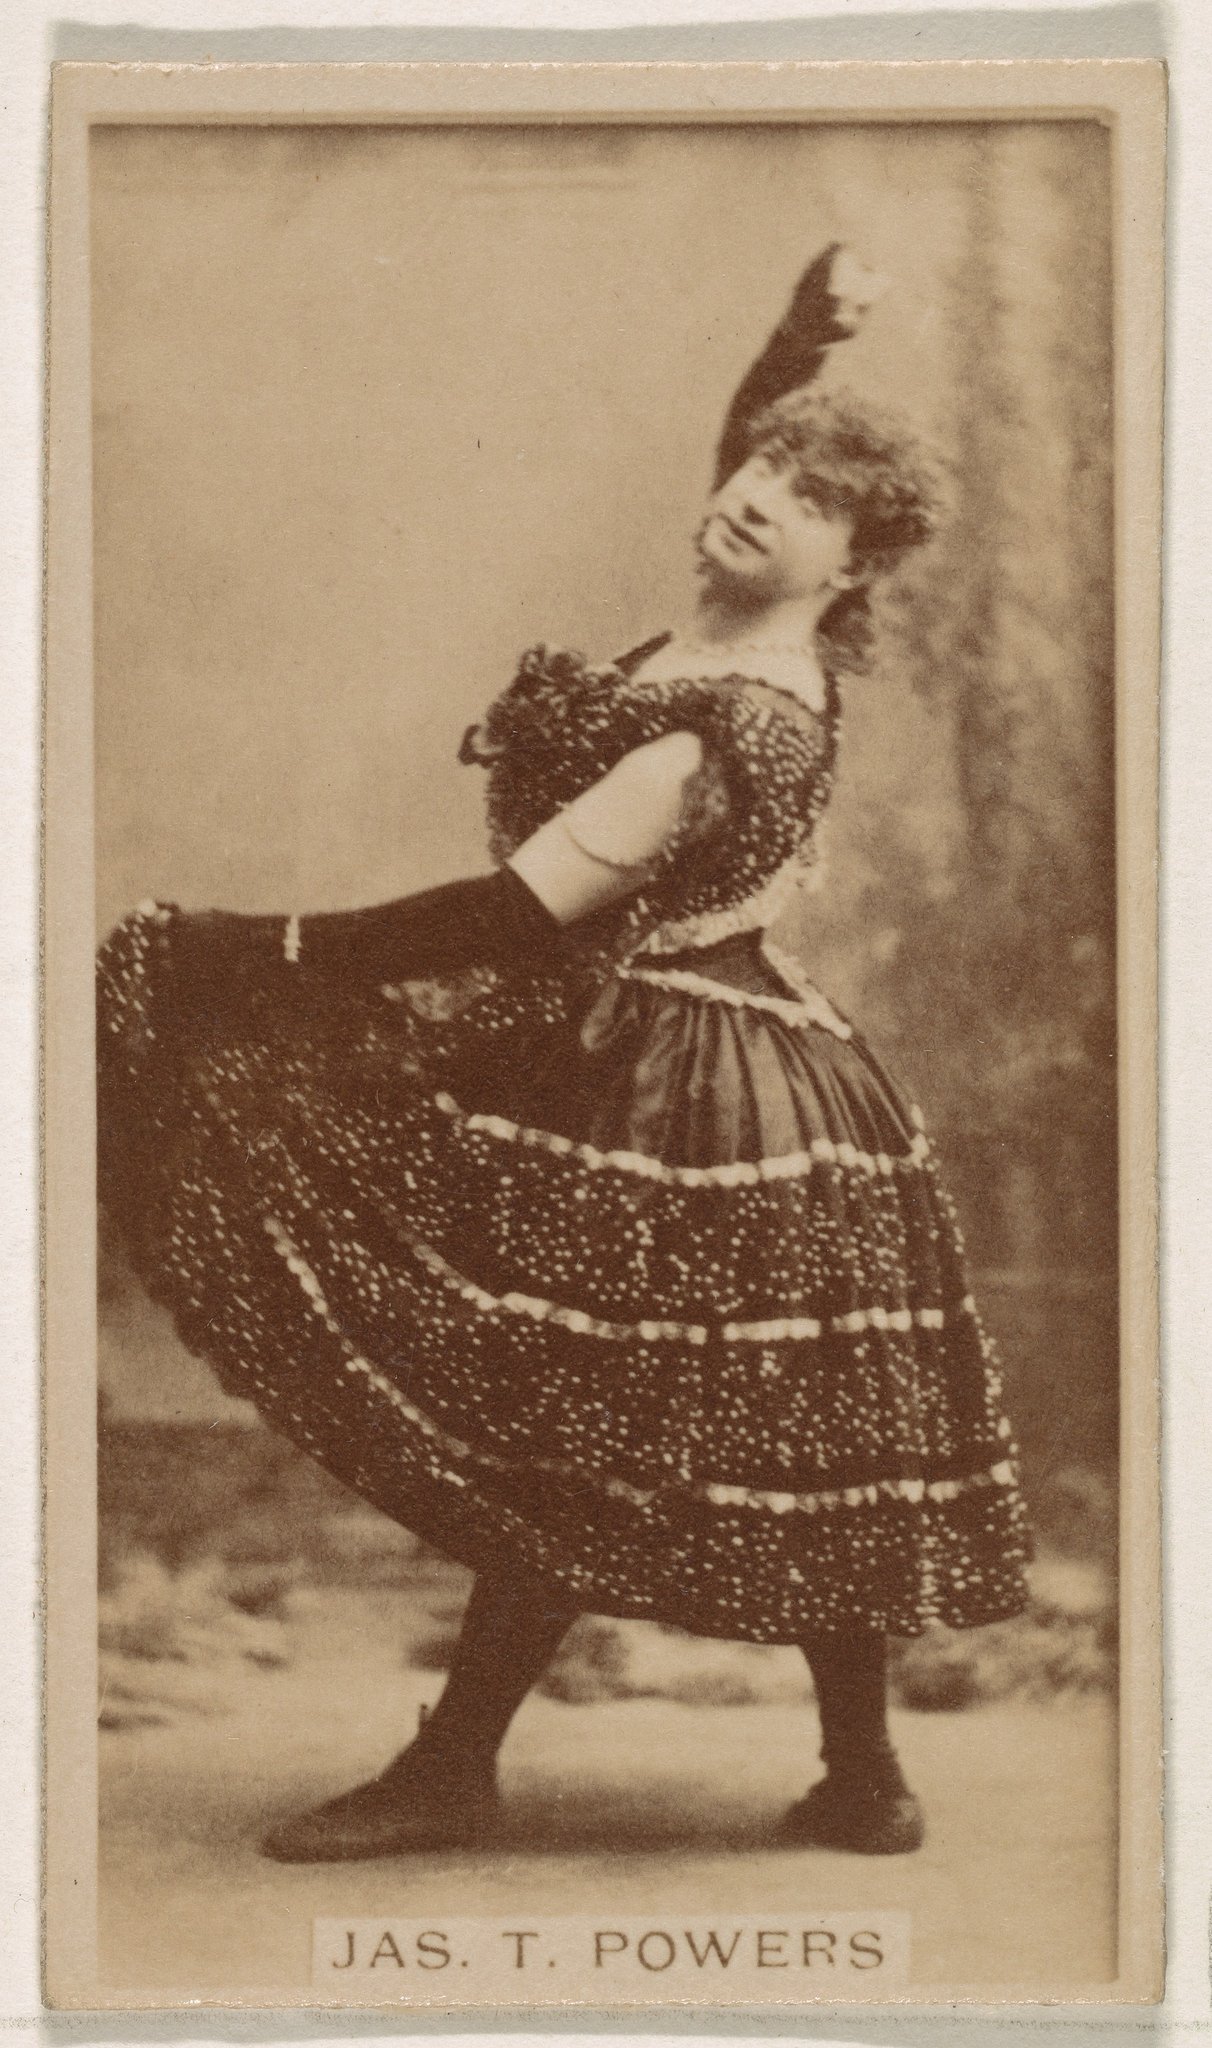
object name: photograph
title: Jas. T. Powers, from the Actresses series (N245) issued by Kinney Brothers to promote Sweet Caporal Cigarettes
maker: kinney brothers tobacco company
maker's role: publisher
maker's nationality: american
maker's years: 1869-2011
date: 1890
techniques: albumen silver print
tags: portraits,women,actresses